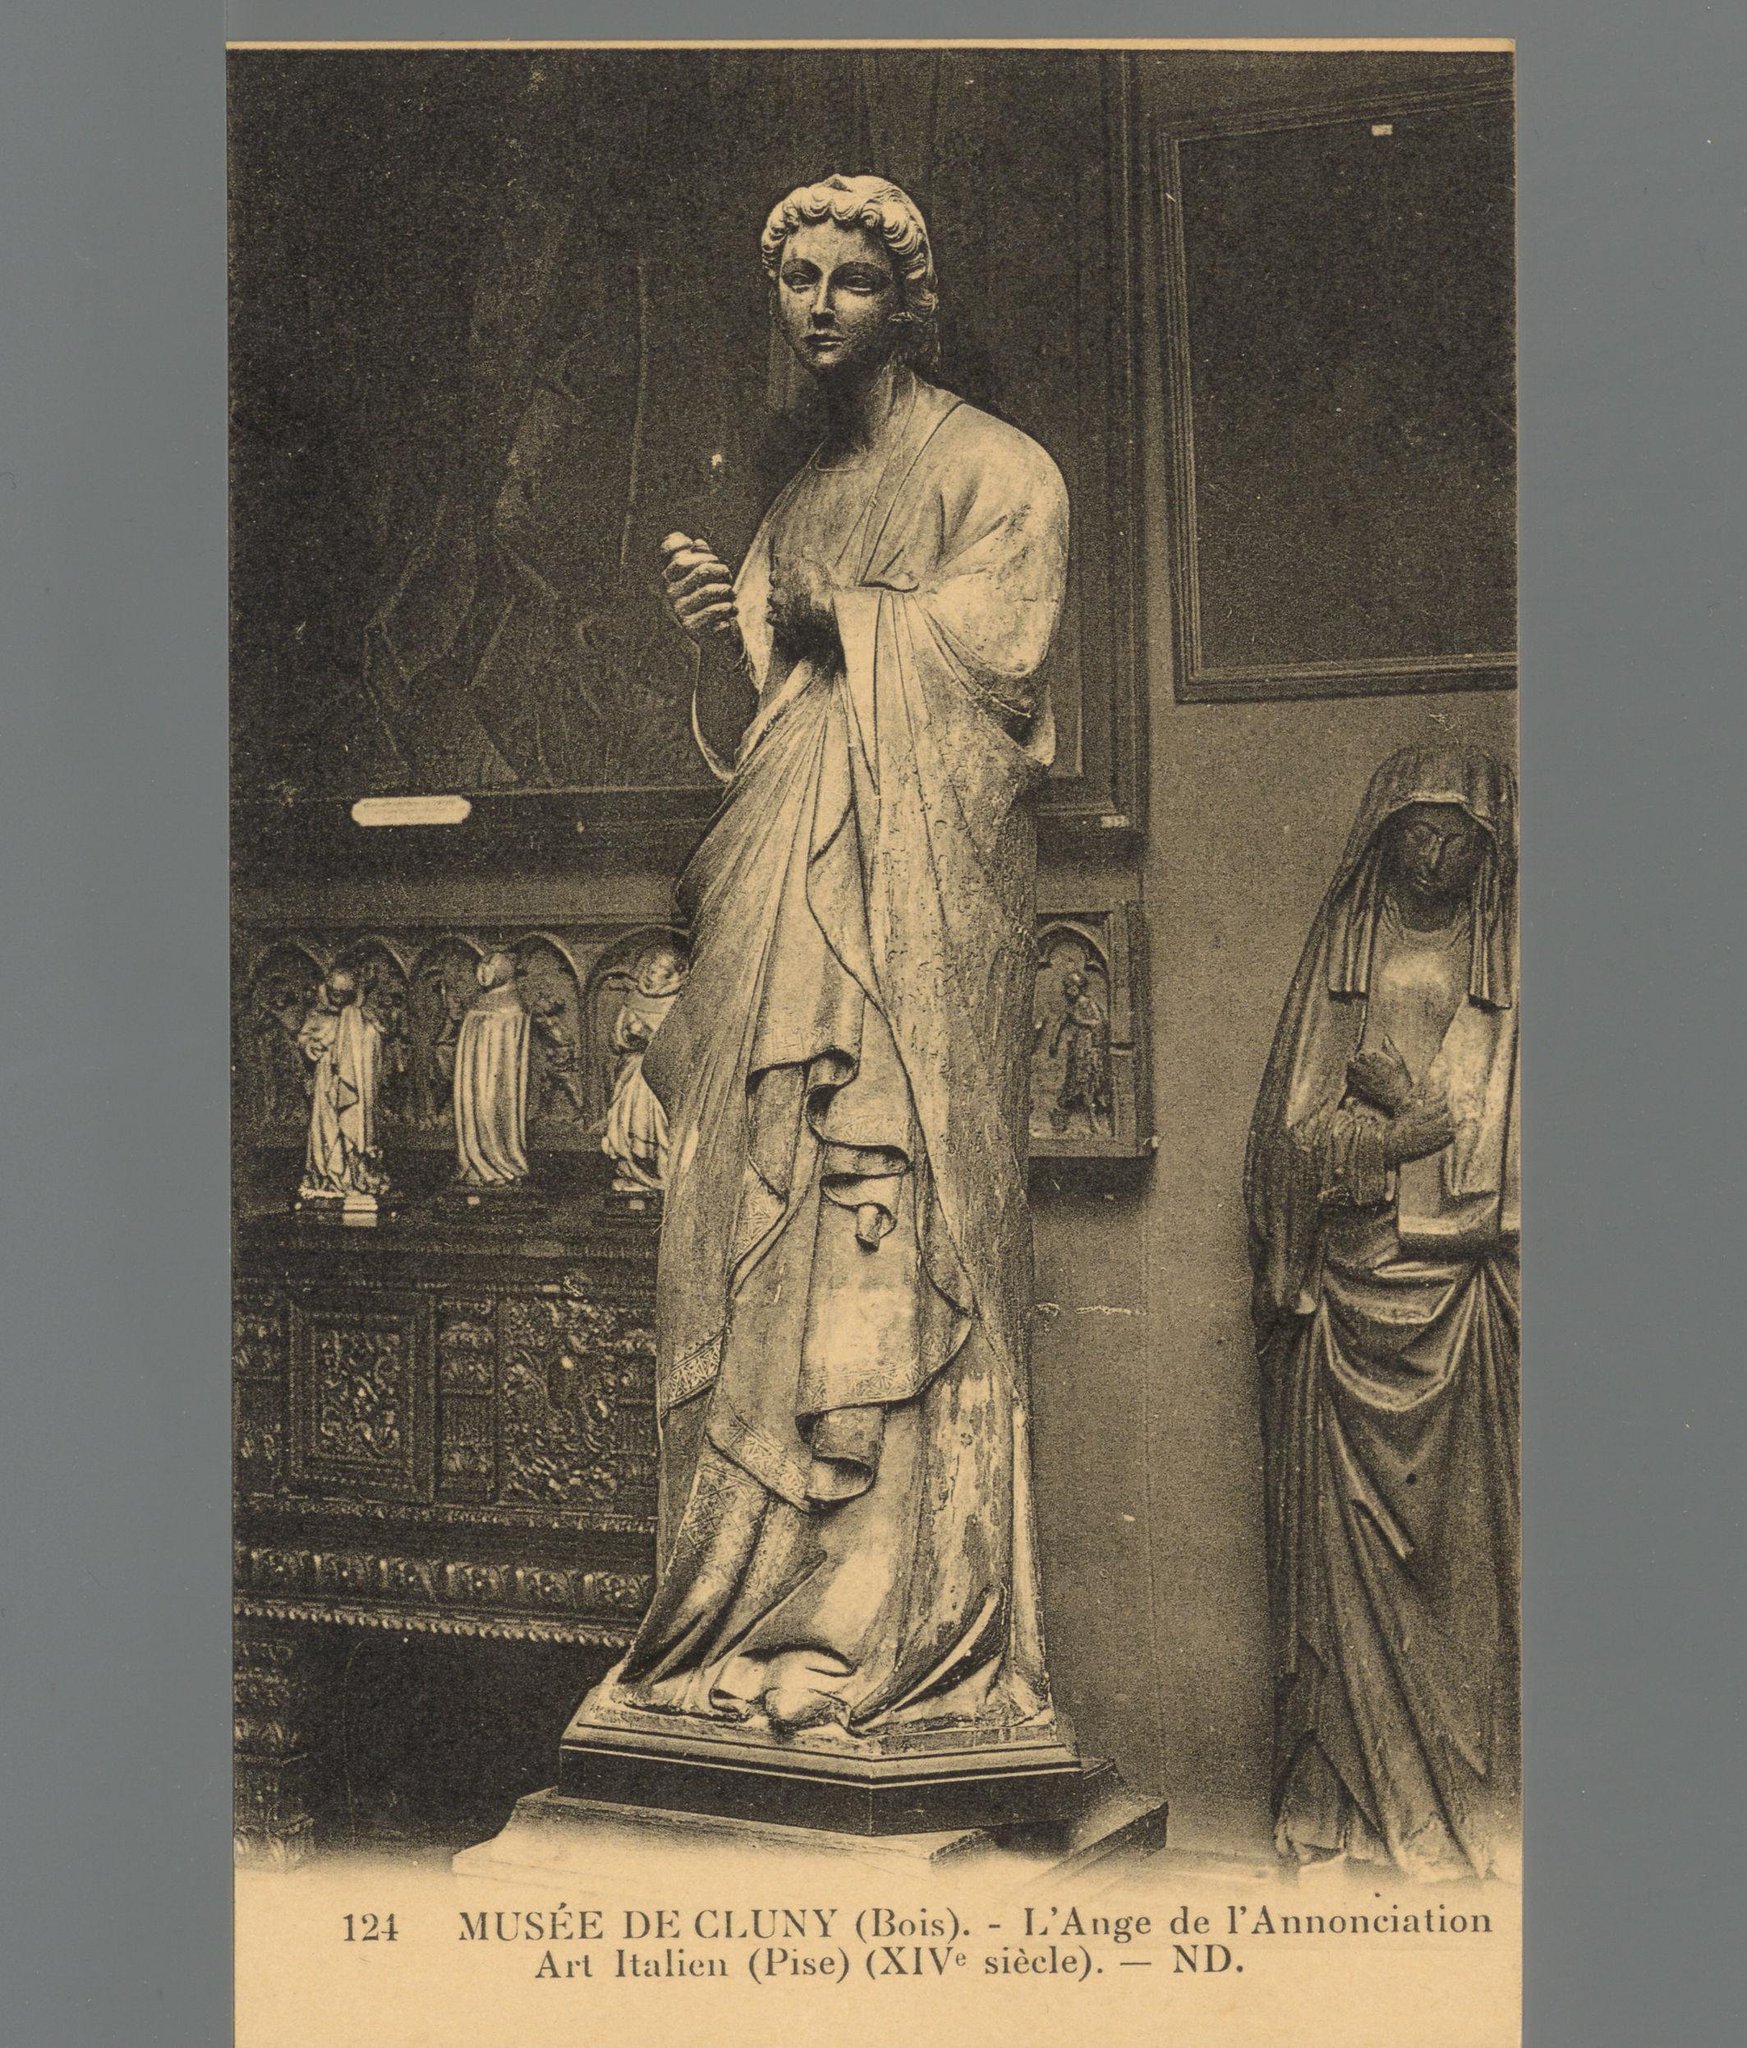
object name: photomechanical print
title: Musée de Cluny (Bois) - L'Ange de l'Annonciation Art Italien (Pise) (XIVe siècle)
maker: Anonymous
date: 1903-1932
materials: cardboard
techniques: photograph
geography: paris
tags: statues, paintings, etc. ~ objects of worship in roman religion, permanent exhibition, museum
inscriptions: collector's mark: ‘AFE v S’